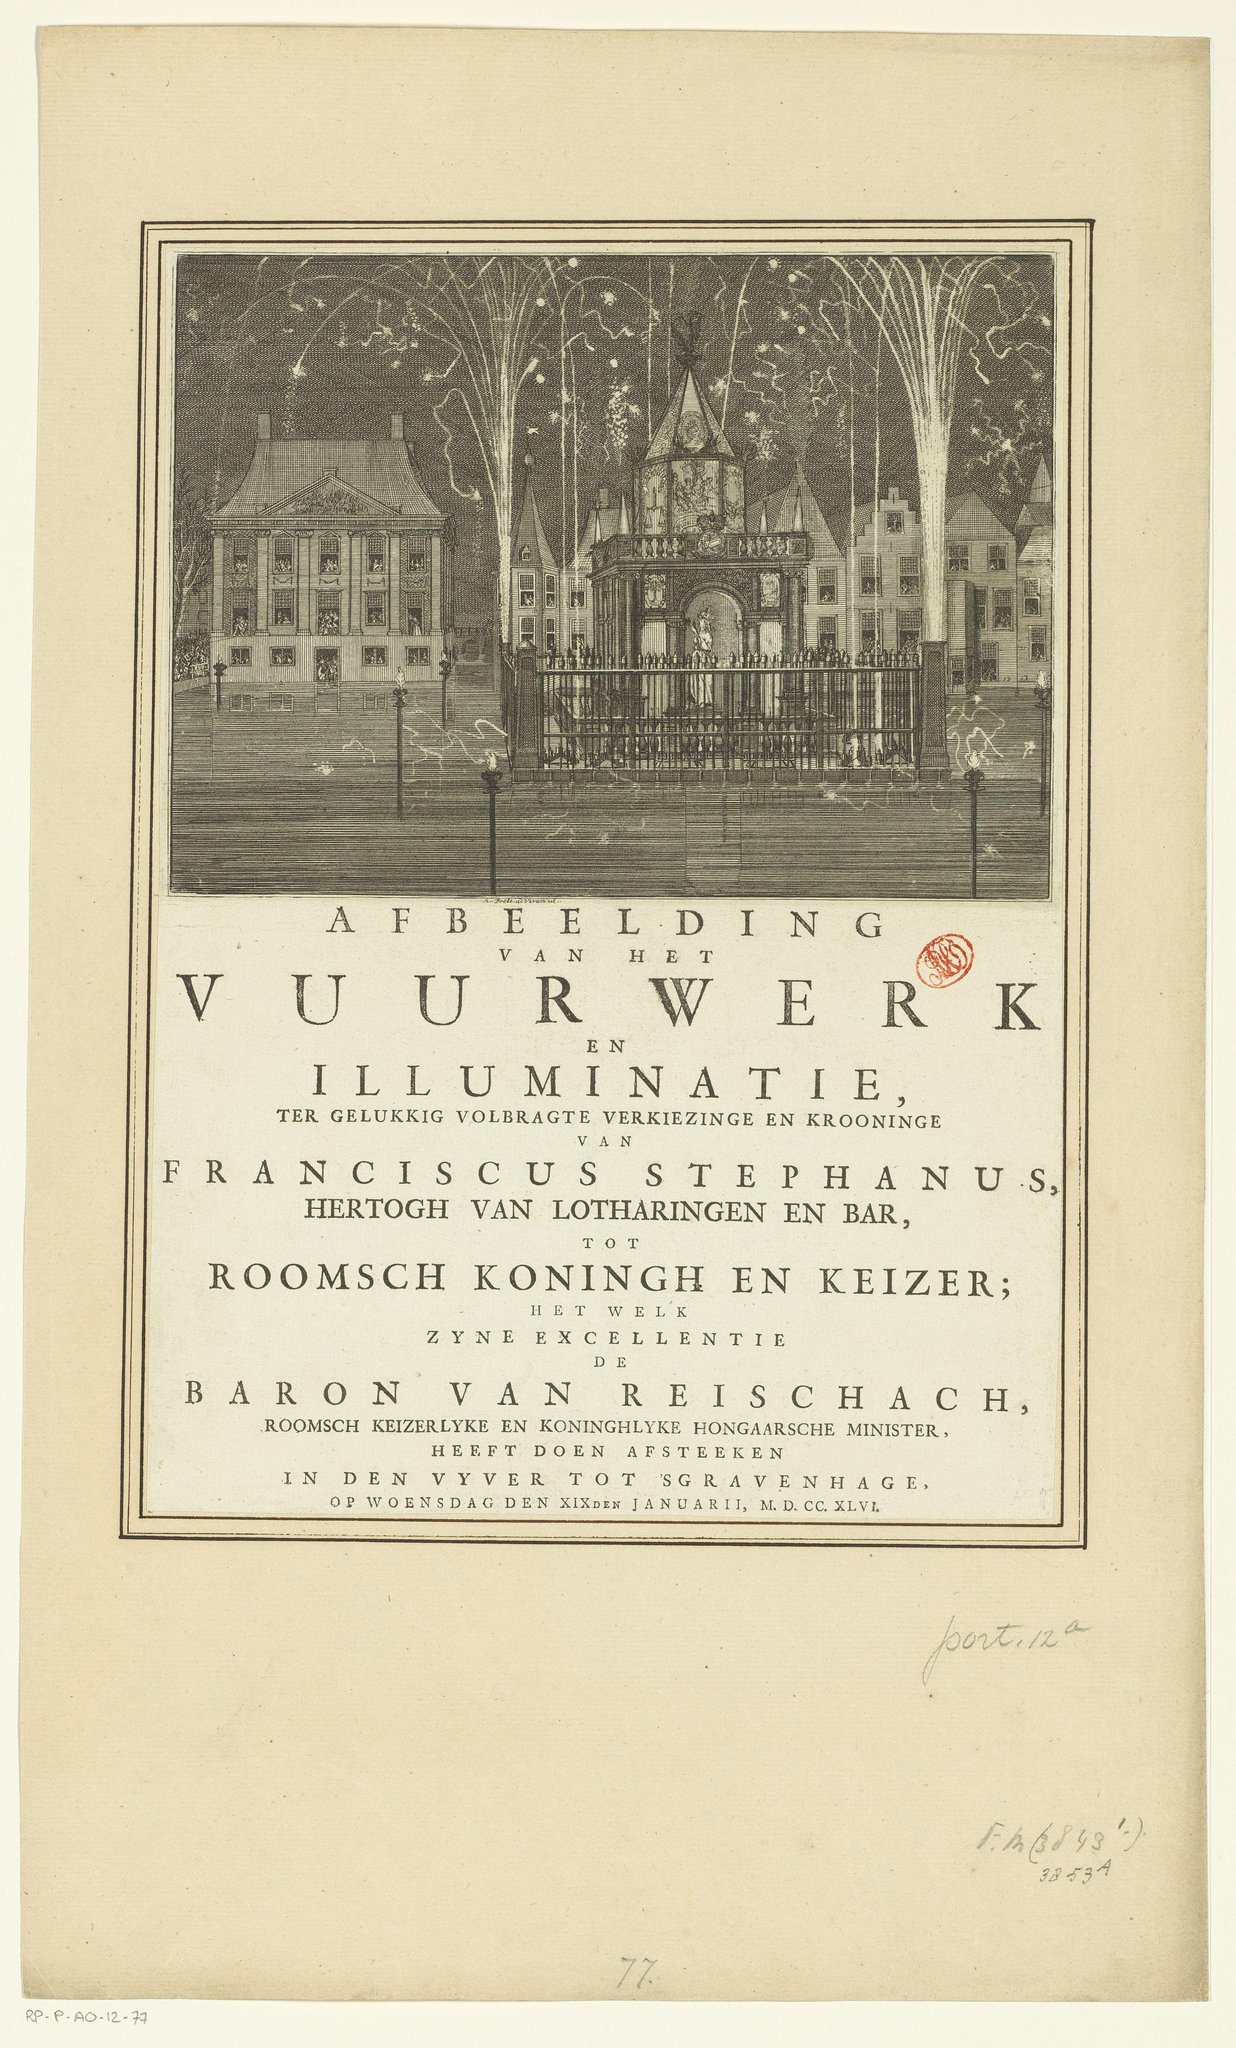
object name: print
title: Vuurwerk te Den Haag bij de kroning van Frans I Stefan tot keizer, 1746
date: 1746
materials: paper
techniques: etching, letterpress printing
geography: northern netherlands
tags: frans i stefan (duits keizer), coronation of a ruler, bonfire, fire-works (+ illumination, fire-works ~ festive activities)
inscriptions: collector's mark: Lugt 195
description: Vuurwerk afgestoken op 19 januari 1746 in de Hofvijver te Den Haag ter gelegenheid van de kroning van Frans I Stefan tot keizer op 4-6 oktober 1745. Het vuurwerk is afgestoken in opdracht van de baron van Reischach, minister in de Republiek namens de Duitse keizerskroon. Links op de achtergrond het Mauritshuis. De titel gedrukt op het blad onder de plaat.